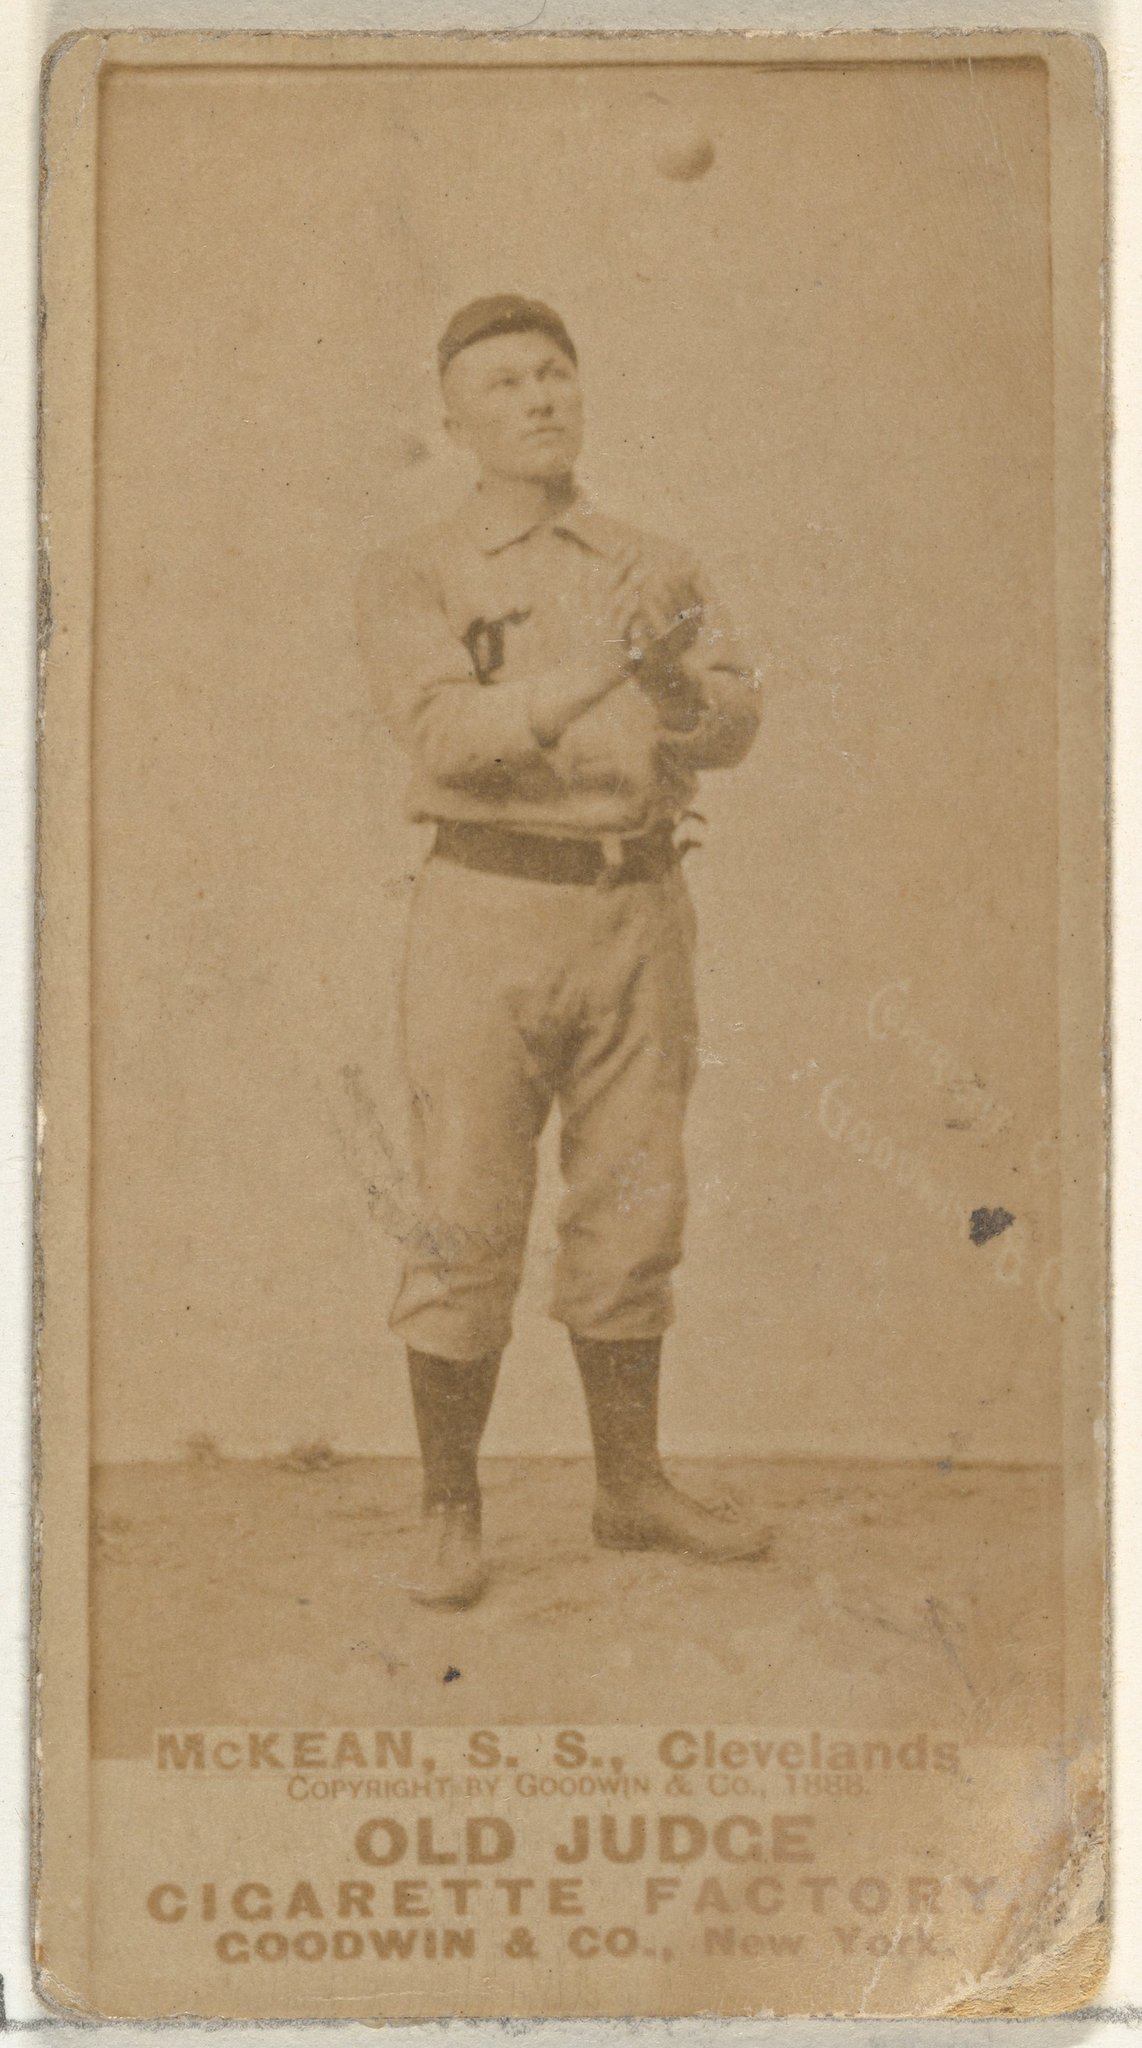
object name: baseball card, photograph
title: Edwin John "Ed" McKean, Shortstop, Cleveland, from the Old Judge series (N172) for Old Judge Cigarettes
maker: goodwin & company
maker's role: publisher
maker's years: 1850-1950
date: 1888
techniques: albumen silver print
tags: men,portraits,baseball,athletes